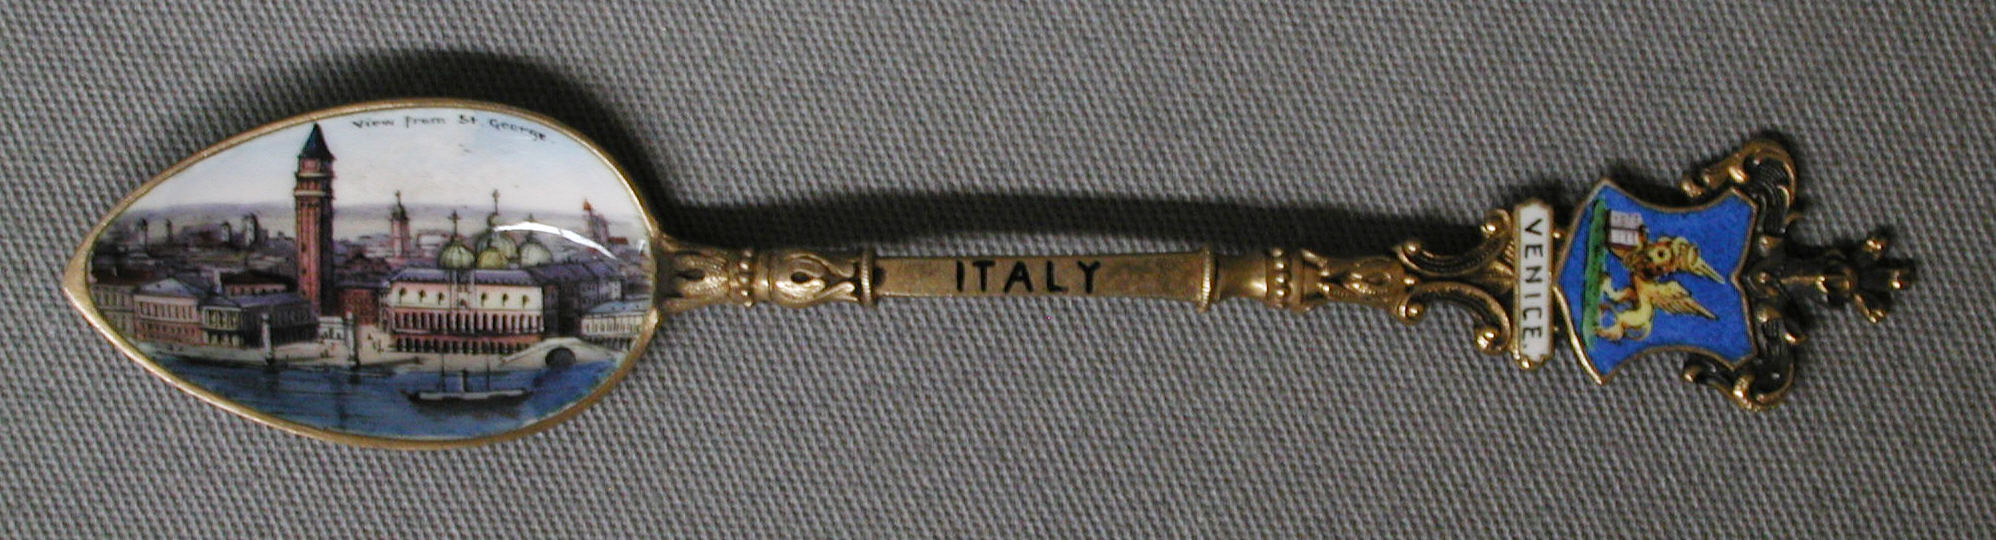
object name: souvenir spoon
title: Souvenir spoon with view of the Doge's Palace and the Campanile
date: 1867-1900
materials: enamel, silver gilt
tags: palaces,coat of arms